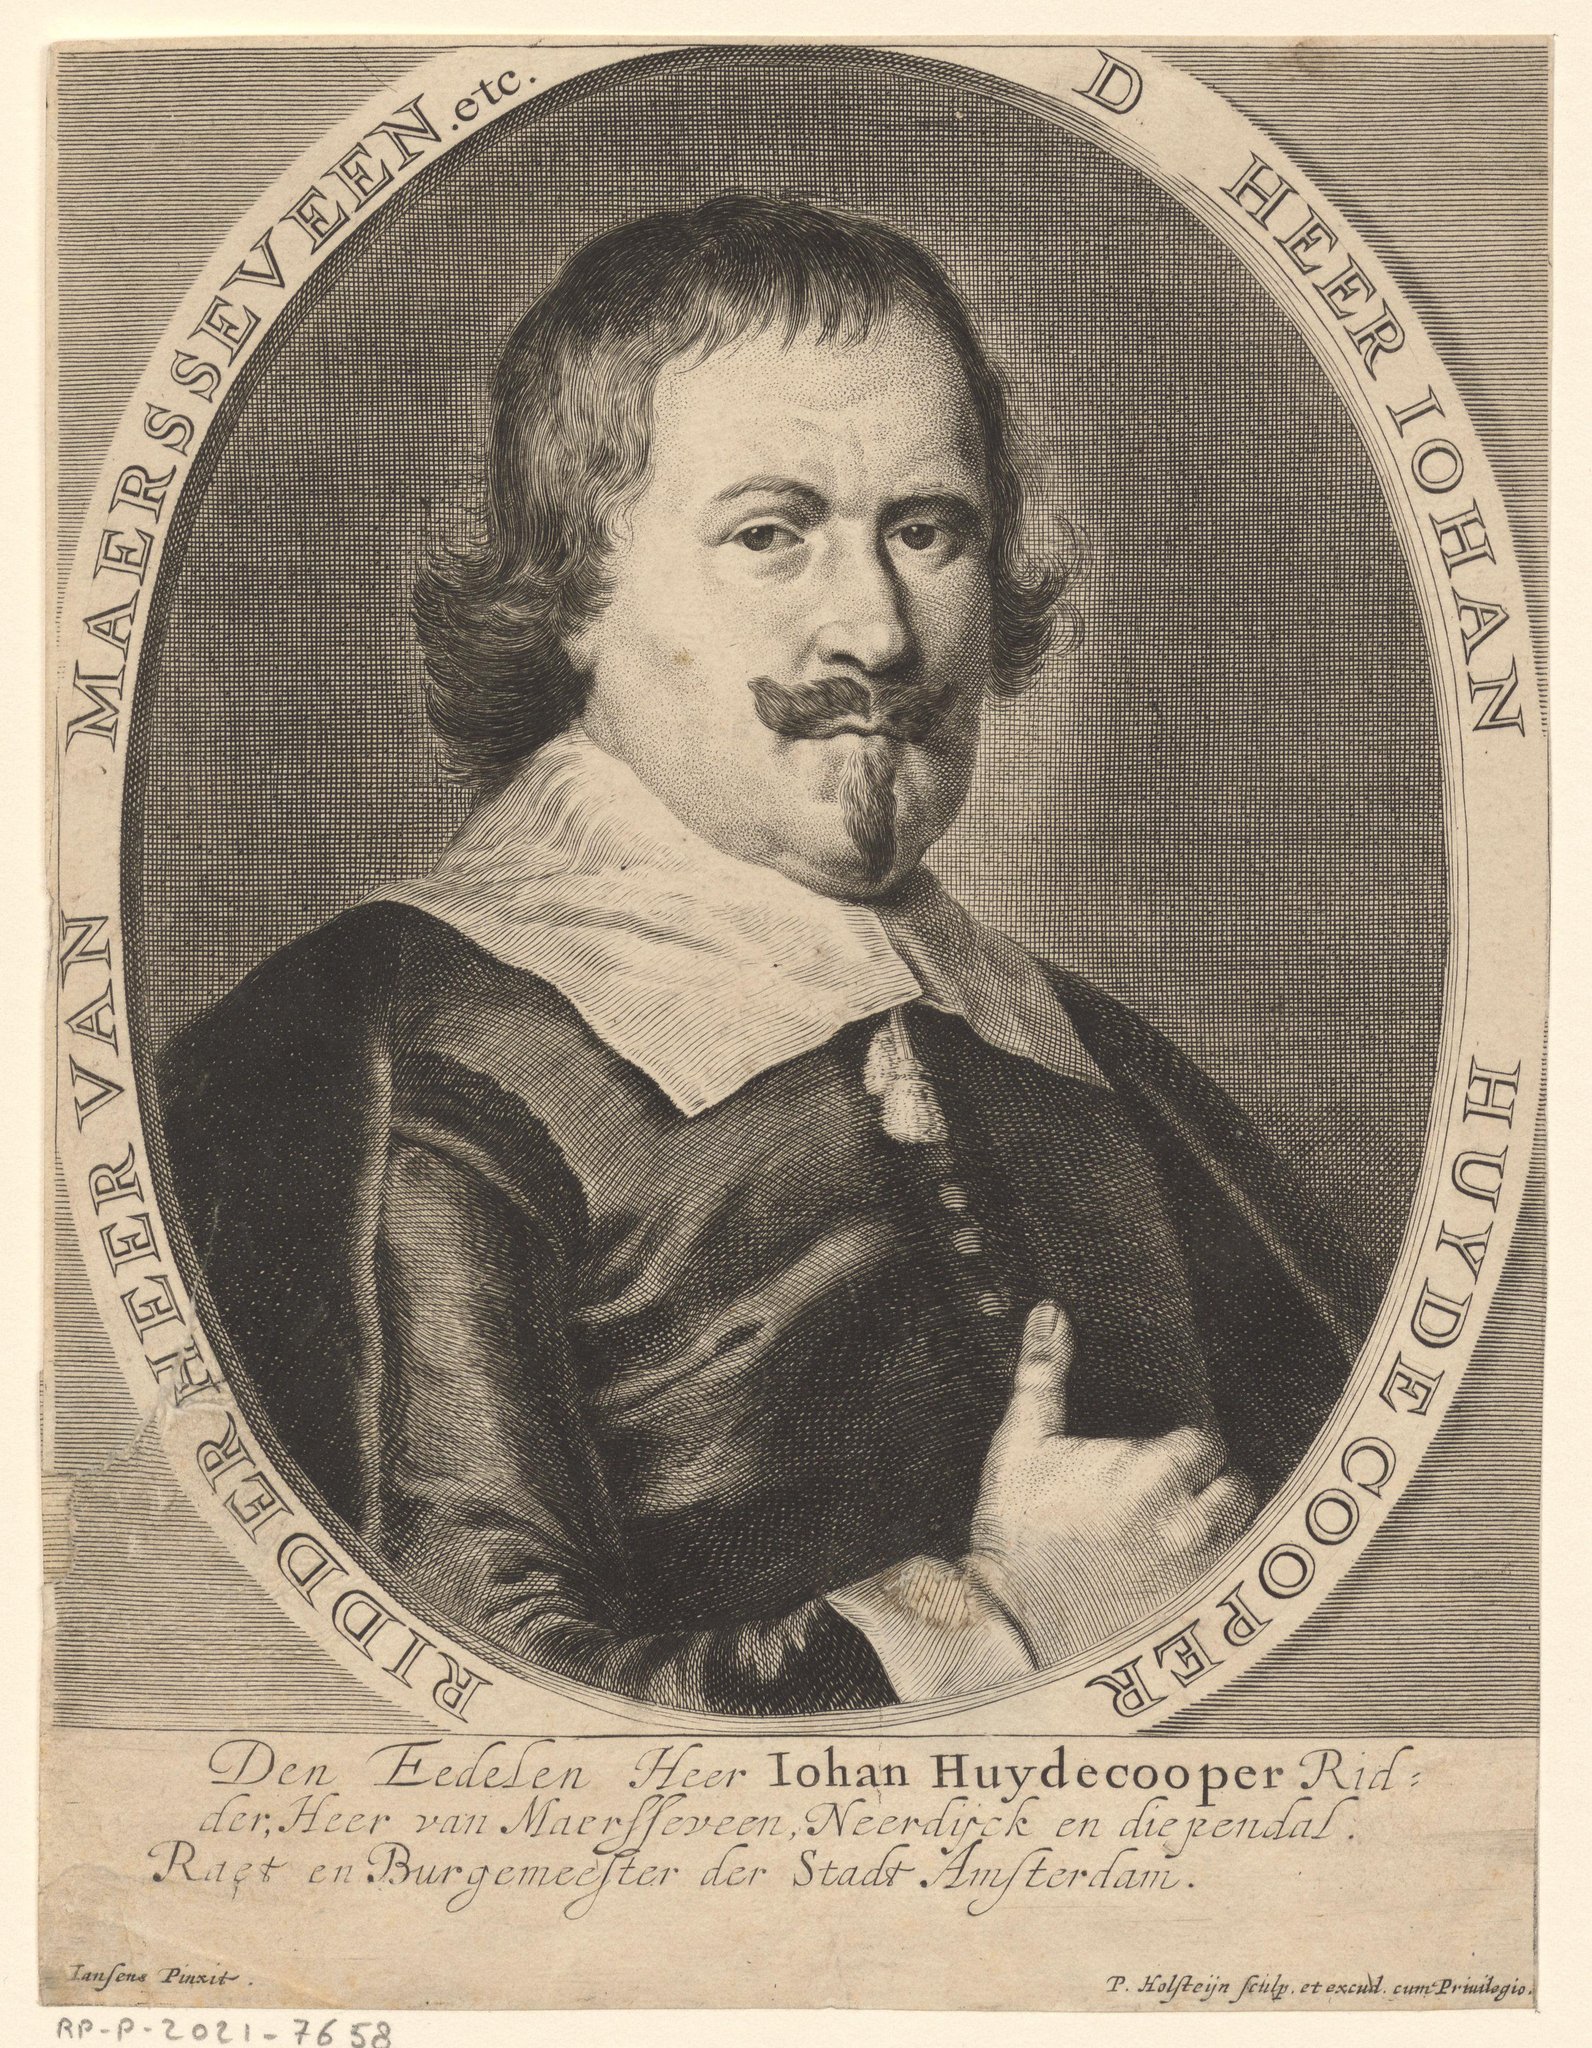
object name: print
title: Portret van Joan Huydecoper van Maarseveen I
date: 1673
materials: paper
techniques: engraving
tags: amsterdam, mayor, joan huydecoper van maarseveen (i), mayor, burgomaster, historical persons